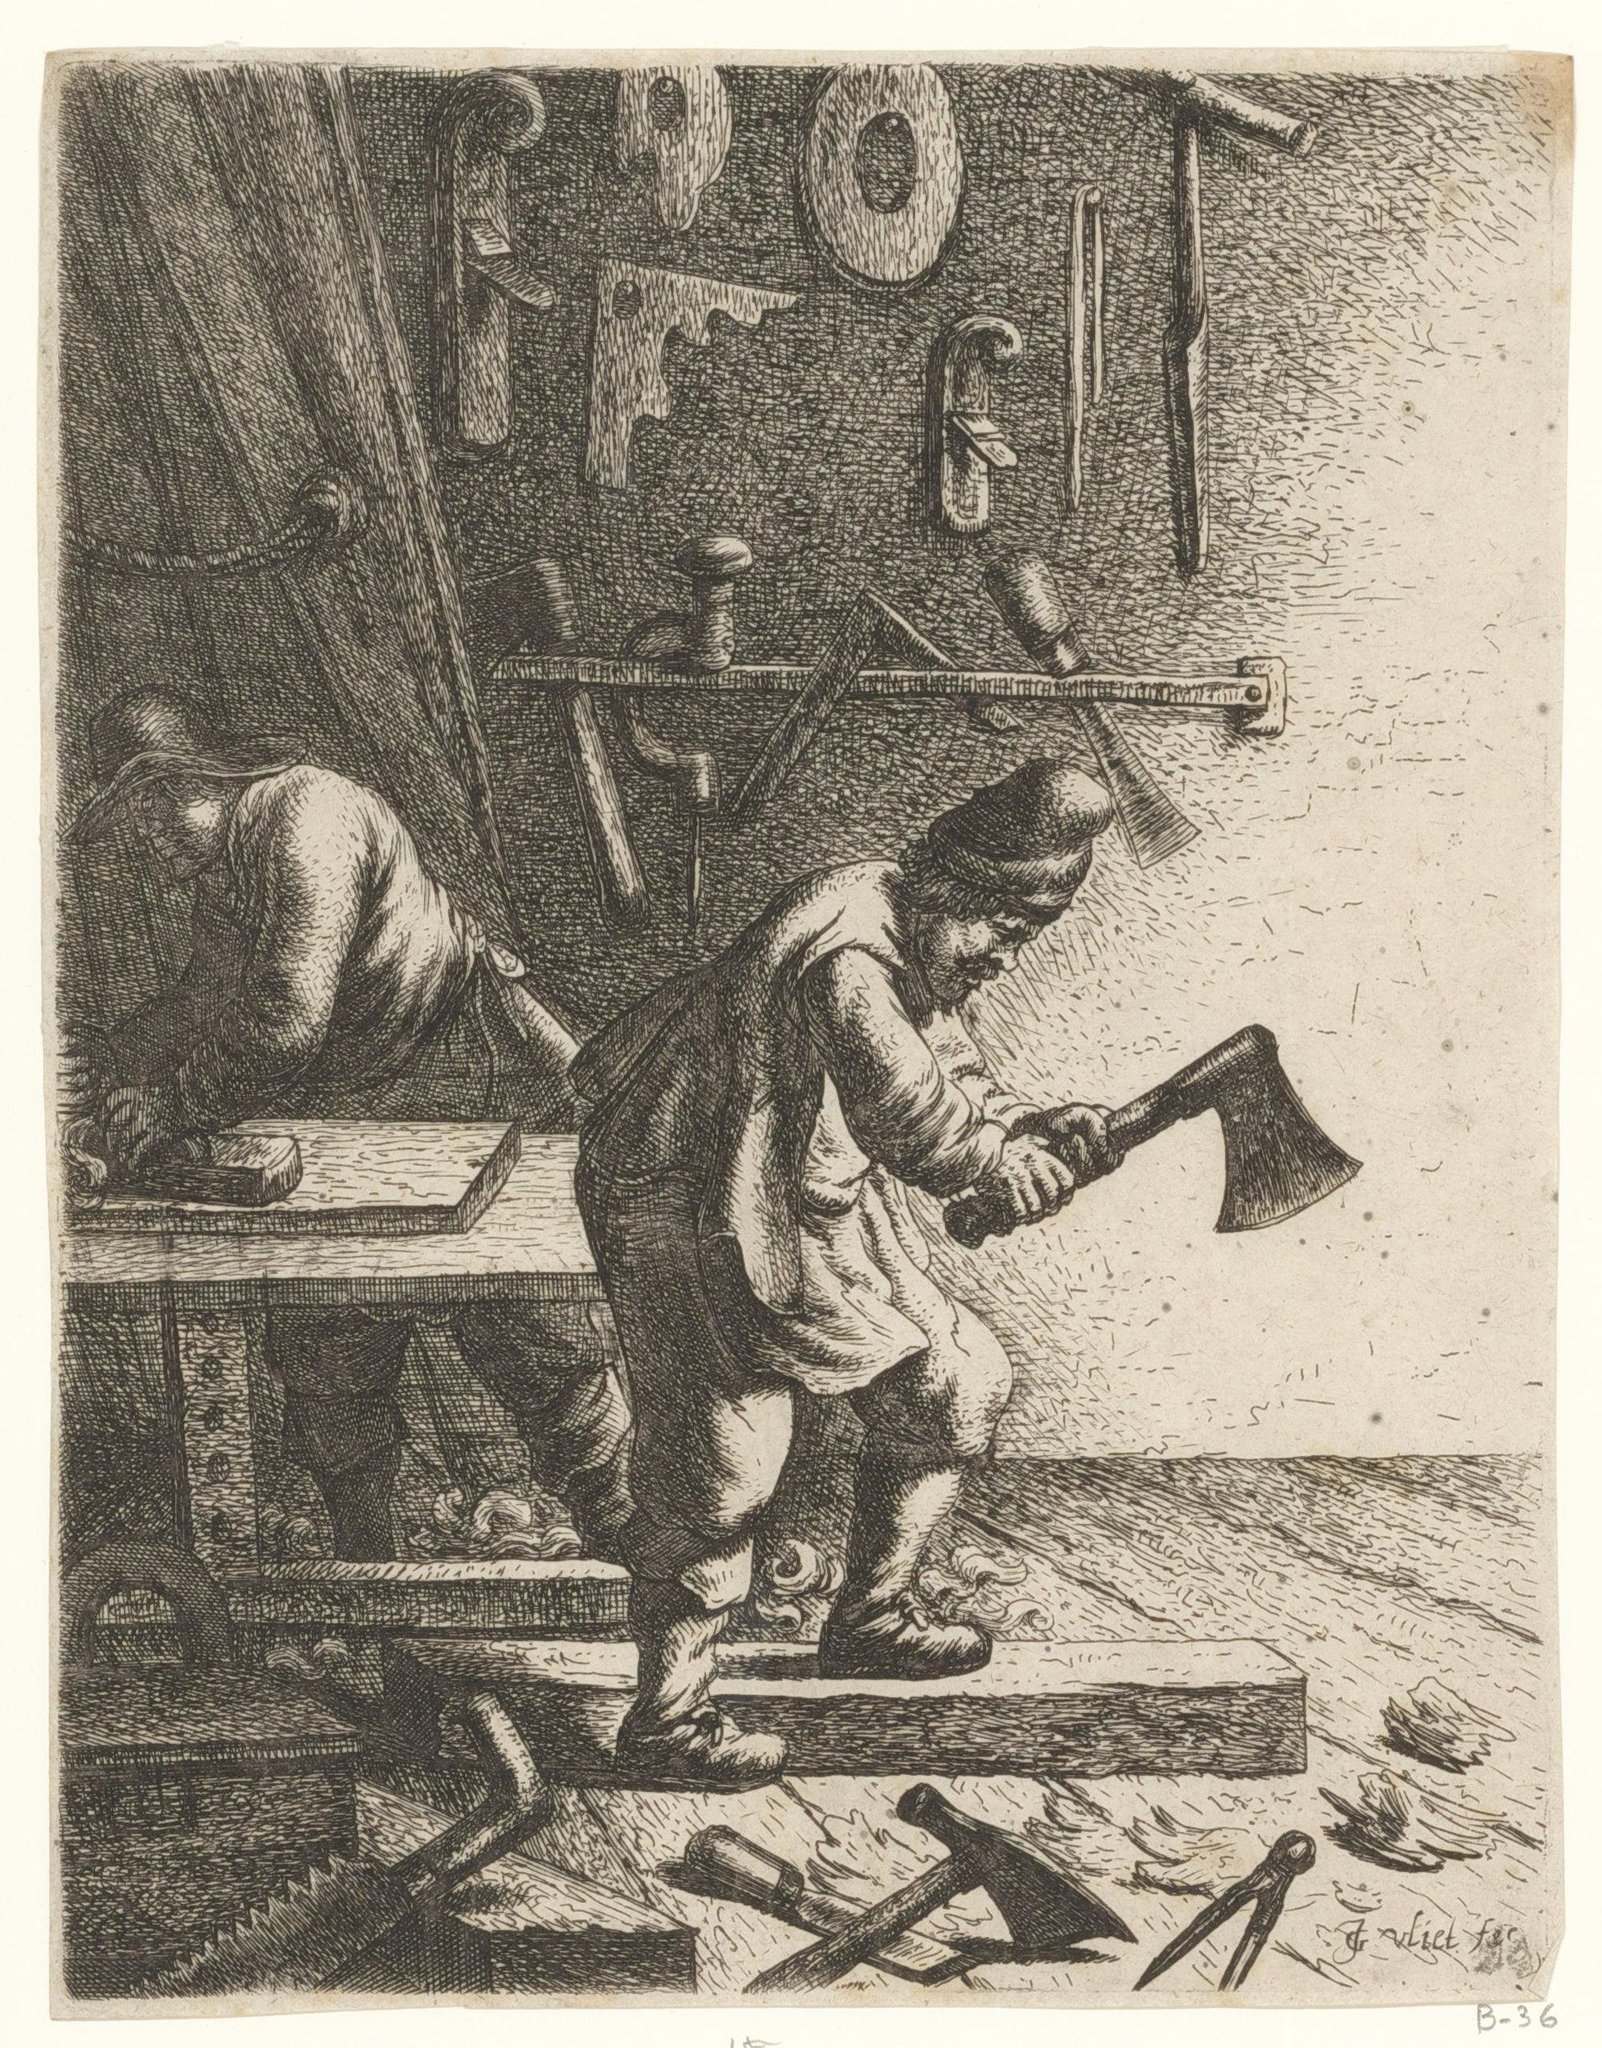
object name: print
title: Timmerlieden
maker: jan gillisz. van vliet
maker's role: draughtsman, painter, print maker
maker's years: 1600-1668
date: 1635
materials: paper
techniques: etching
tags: tools, aids, implements ~ crafts and industries: chisel, carpenter, tools, aids, implements ~ crafts and industries: plane, tools, aids, implements ~ crafts and industries: axe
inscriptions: collector's mark: Lugt 1641, stamp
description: Een timmerman bewerkt een stuk hout met een bijl. Een tweede timmerman staat achter een schaafbank. Aan de achterwand en op de grond vele werktuigen. Onderwerpsrubrieken binnen de Atlas Zeden en Gewoonten: Handel, Nijverheid en Verkeer, Beroep en bedrijf, Complete suites.